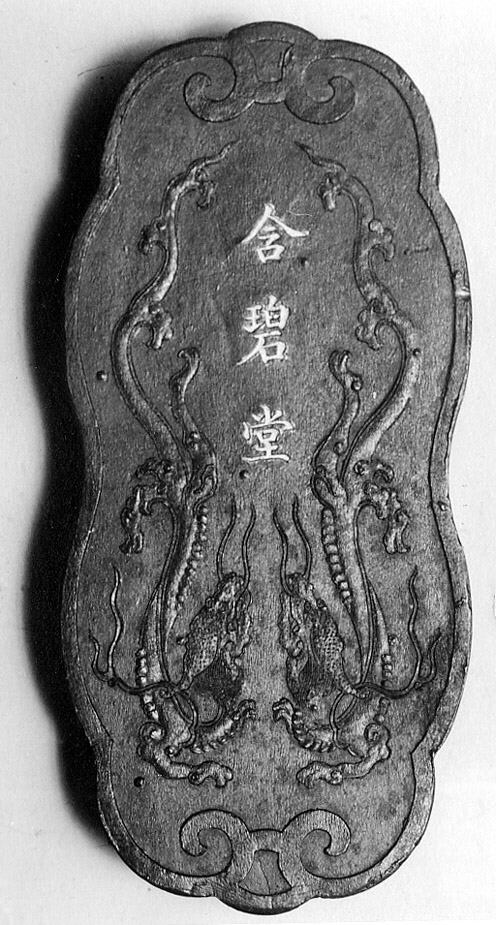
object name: ink tablet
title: Hall that Holds the Green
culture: chinese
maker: jian guzhai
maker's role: artist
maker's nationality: chinese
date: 1867-1933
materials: ink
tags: dragons